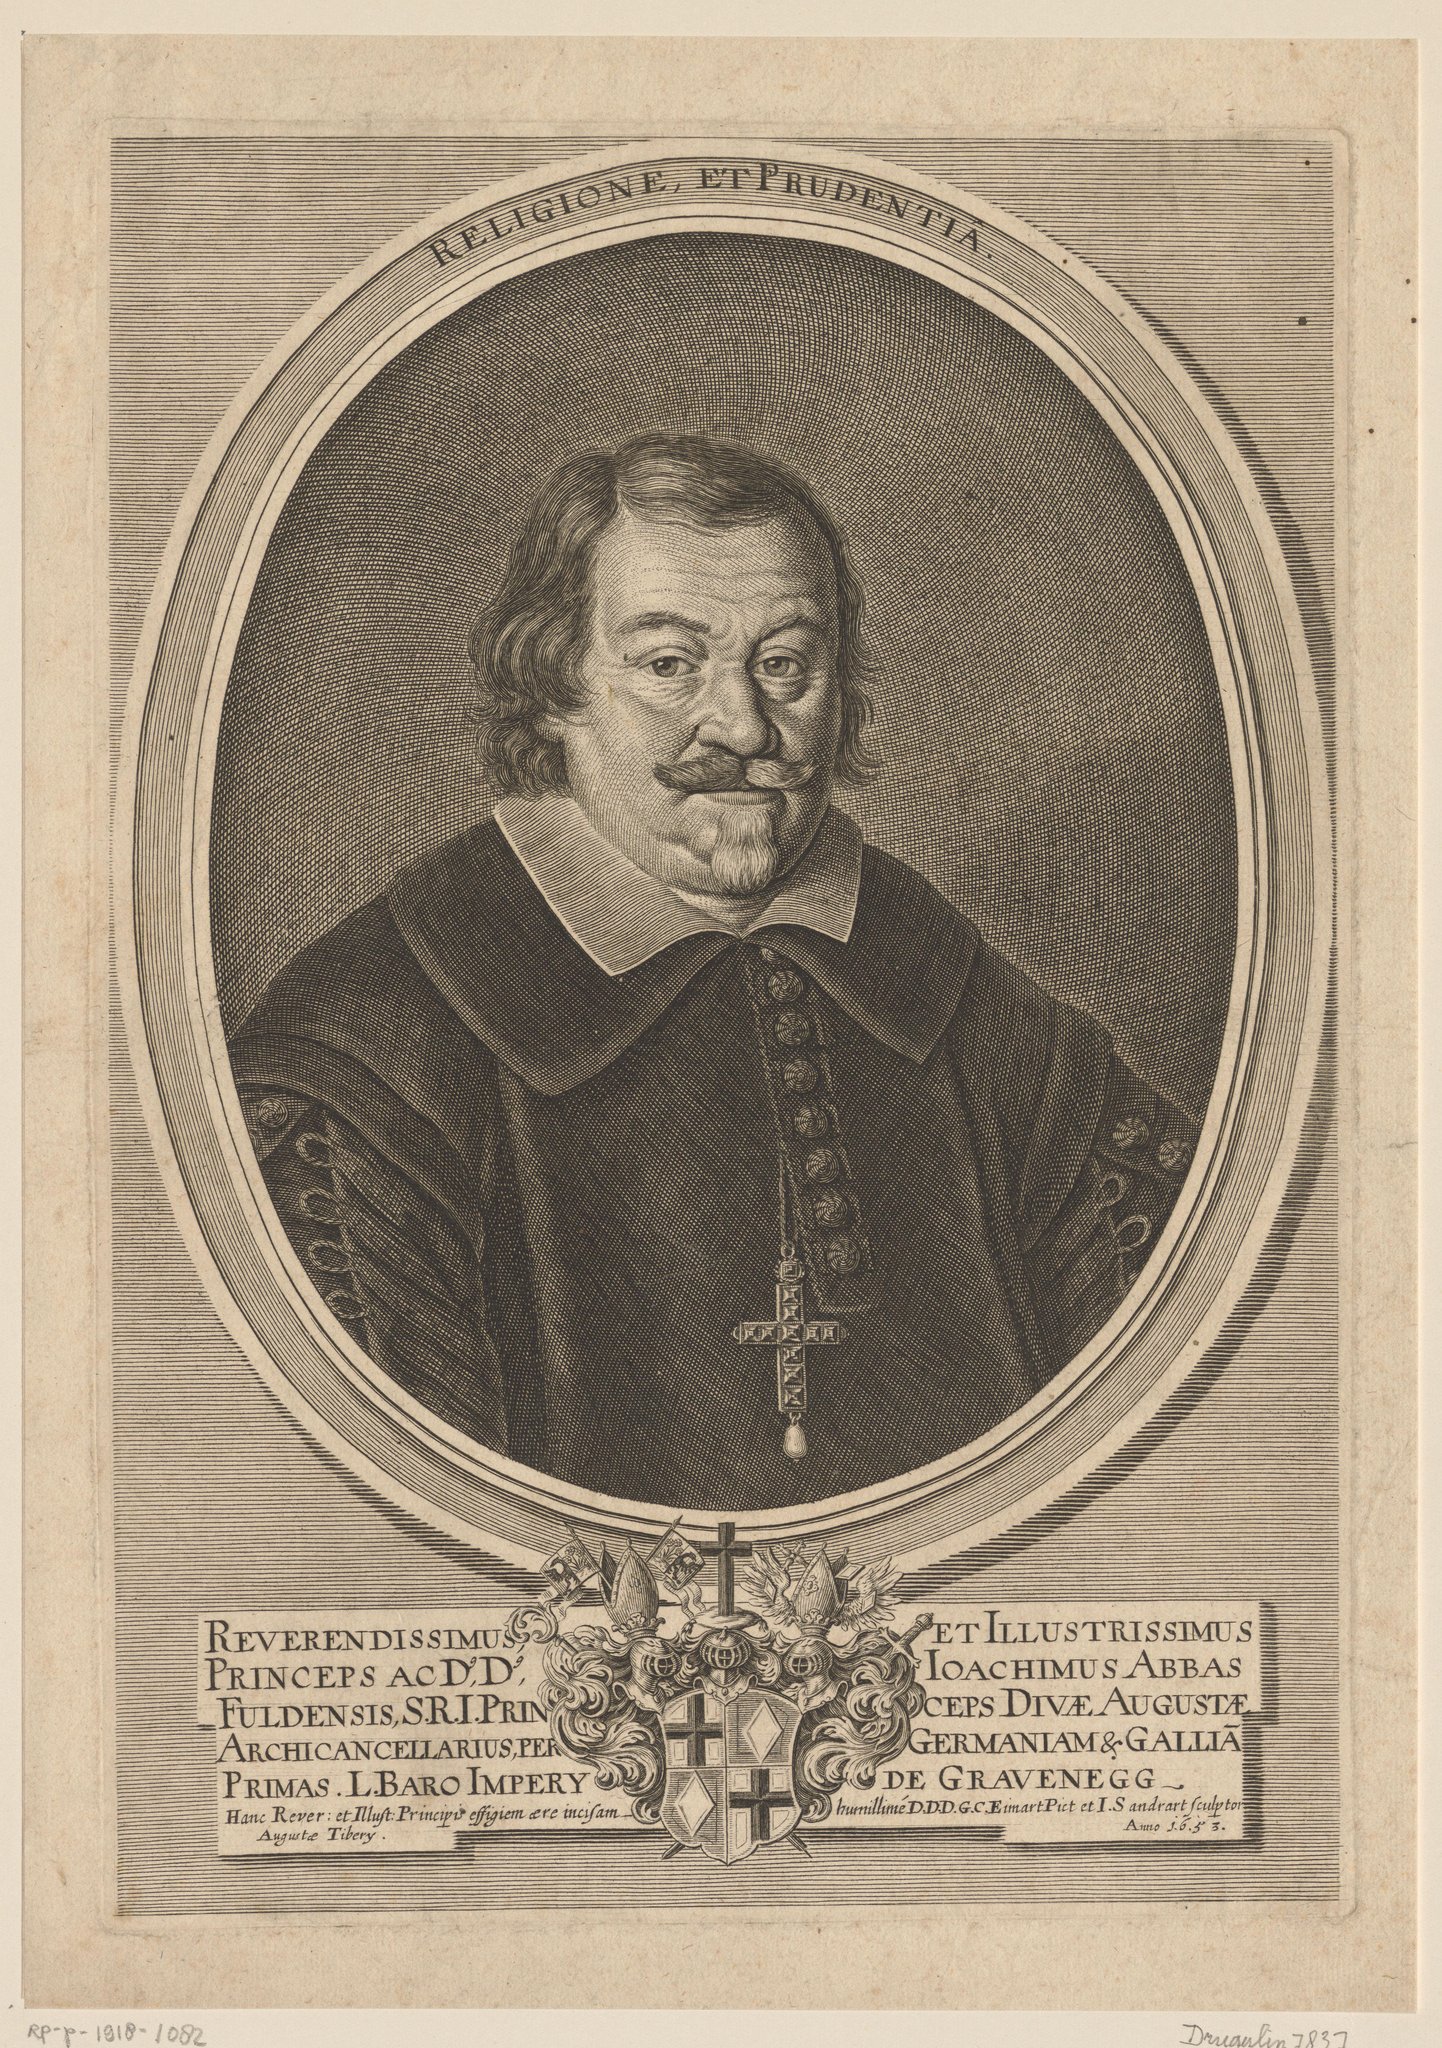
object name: print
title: Portret van Joachim von Gravenegg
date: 1653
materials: paper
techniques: engraving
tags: theologian, historical persons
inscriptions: collector's mark: Lugt 2233